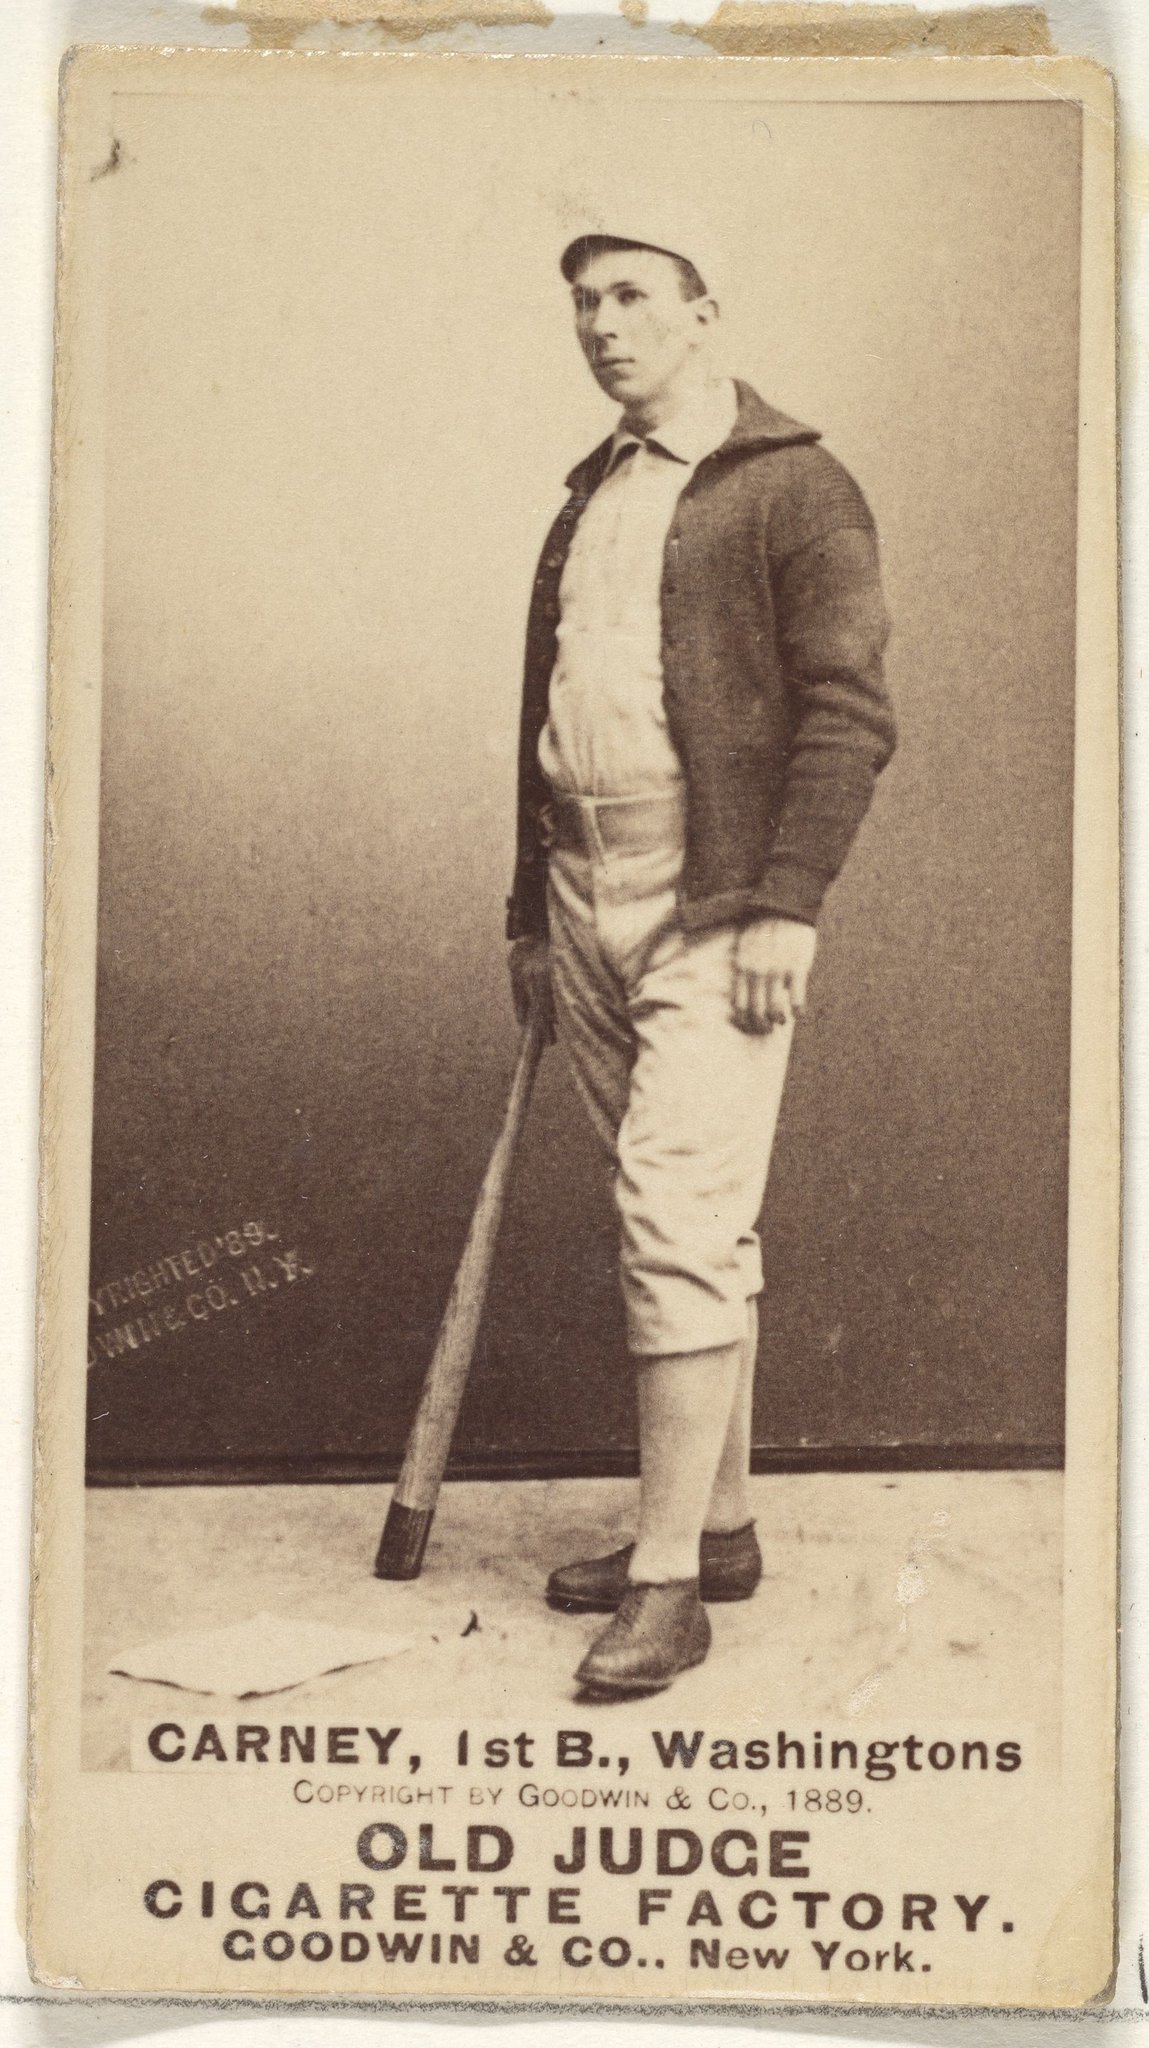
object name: baseball card, photograph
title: John Joseph "Handsome Jack" Carney, 1st Base, Washington Nationals, from the Old Judge series (N172) for Old Judge Cigarettes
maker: goodwin & company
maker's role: publisher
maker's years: 1850-1950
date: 1889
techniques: albumen silver print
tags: men,portraits,baseball,athletes